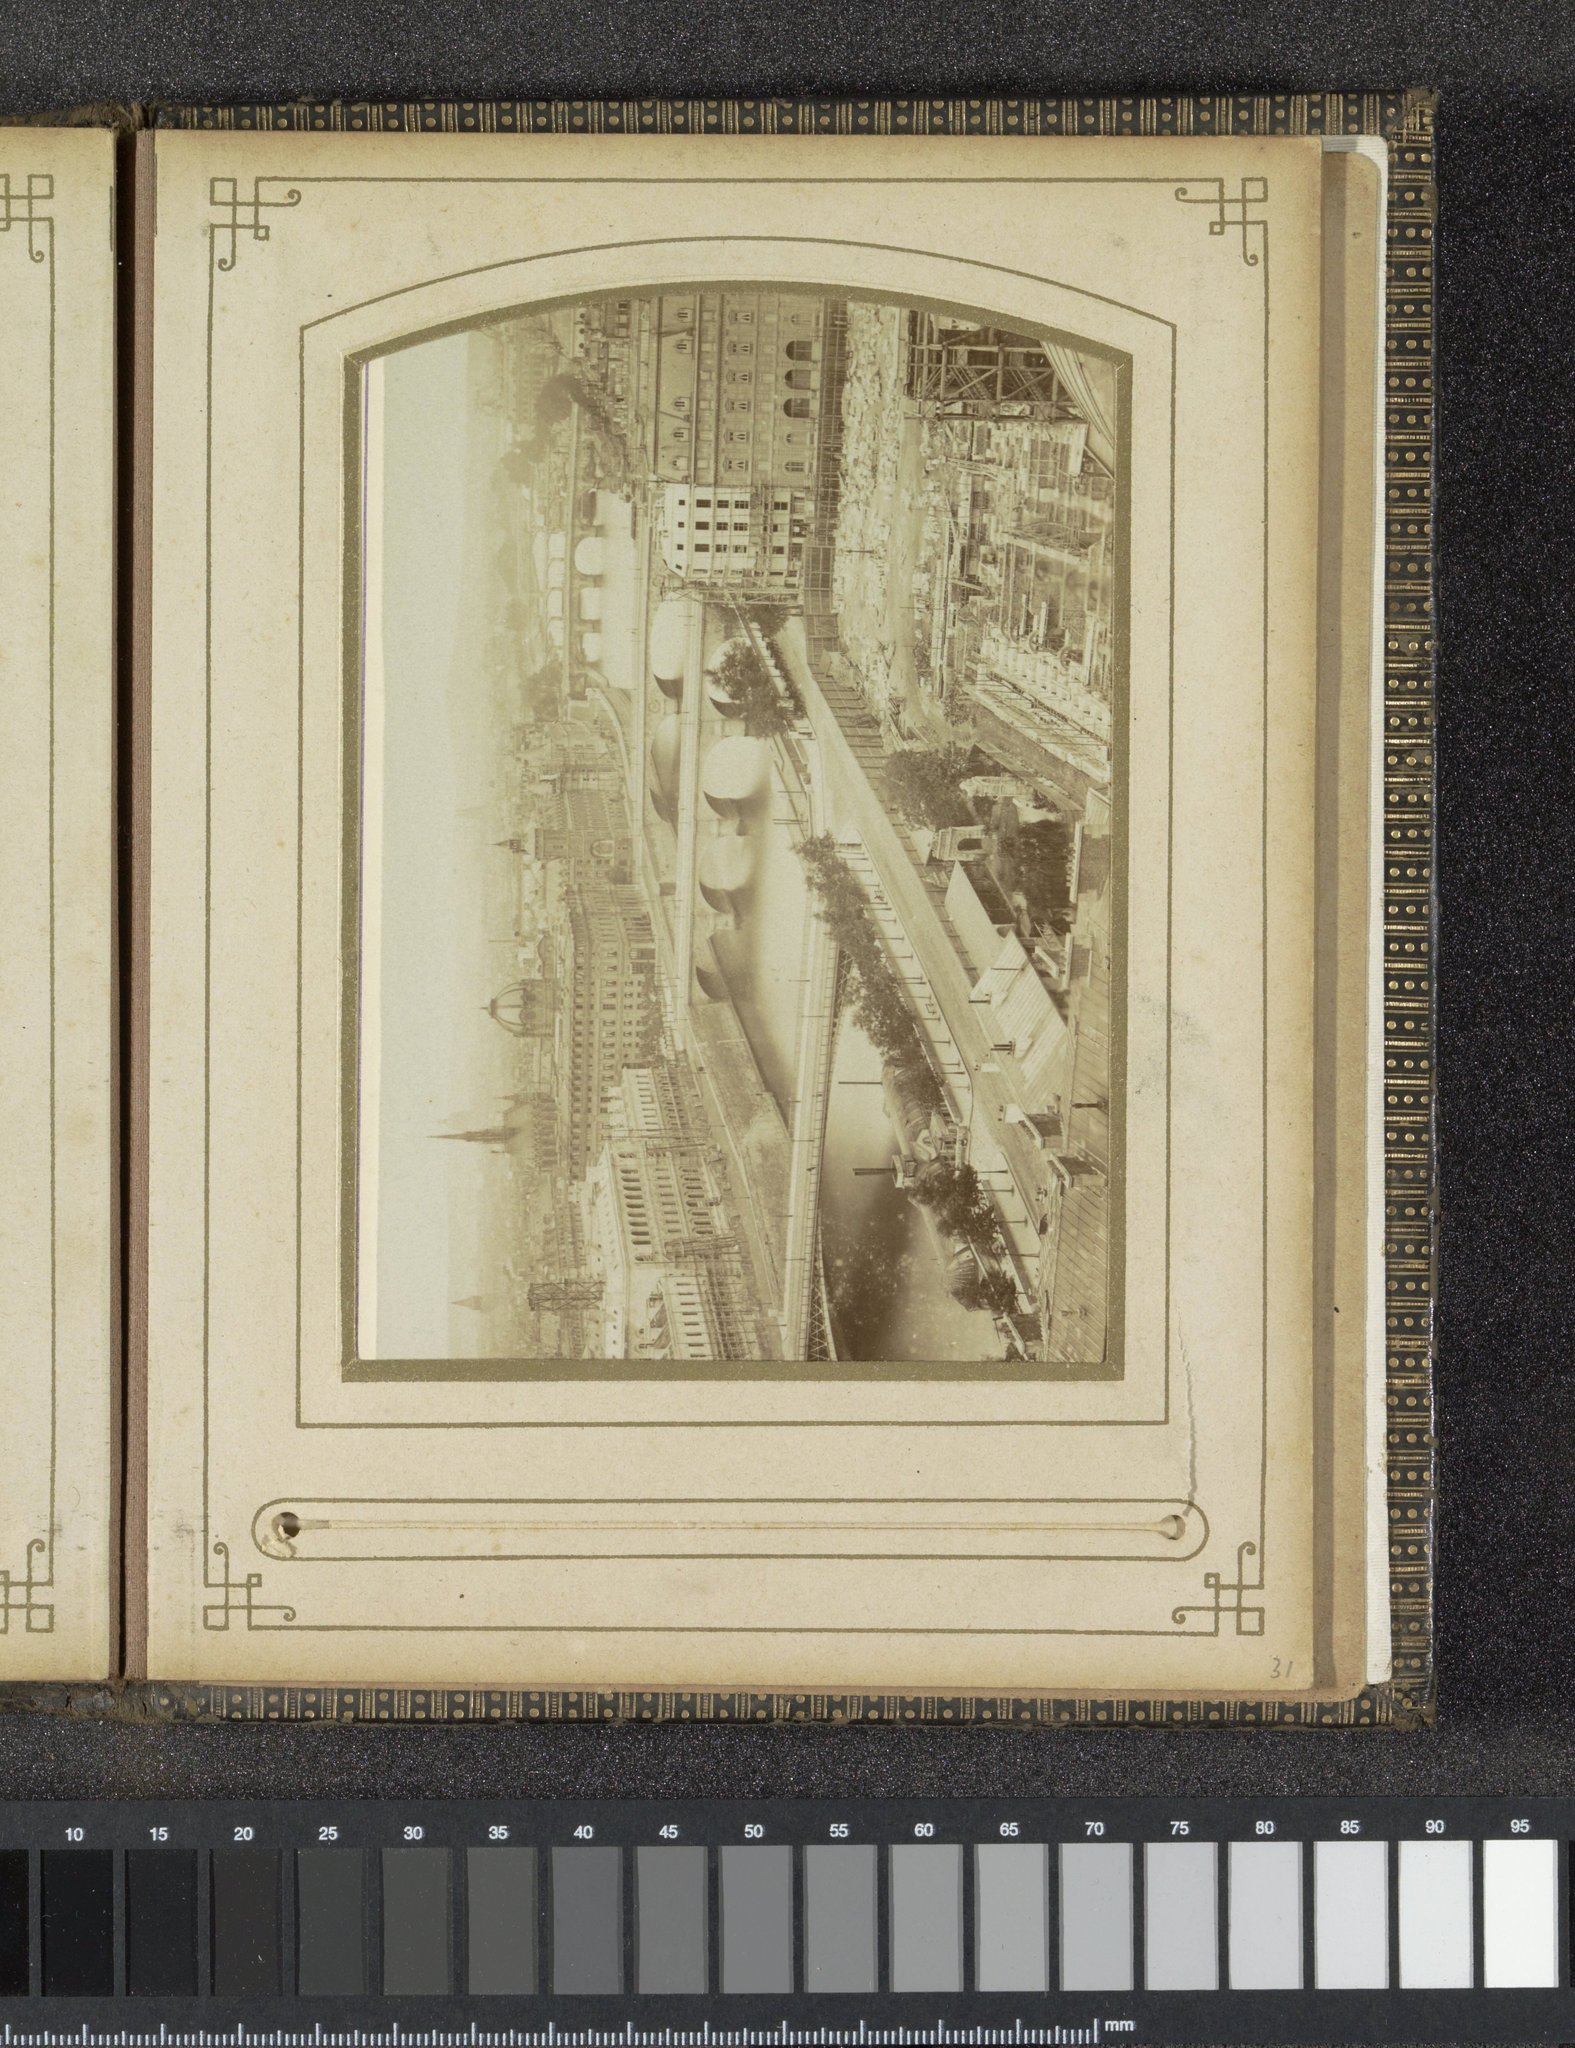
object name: cabinet photograph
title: Gezicht op de Seine en aanliggende bebouwing in Parijs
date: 1870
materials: cardboard, paper, photographic support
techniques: albumen print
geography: paris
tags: bridge in city across river, canal, etc., prospect of city, town panorama, silhouette of city, paris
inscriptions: inscription: ‘Maison Martinet 12, Boulevard des Capucines 12 Grand-Hotel, Paris.’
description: Onderdeel van Fotoalbum met kabinetfoto's van bezienswaardigheden in Parijs.